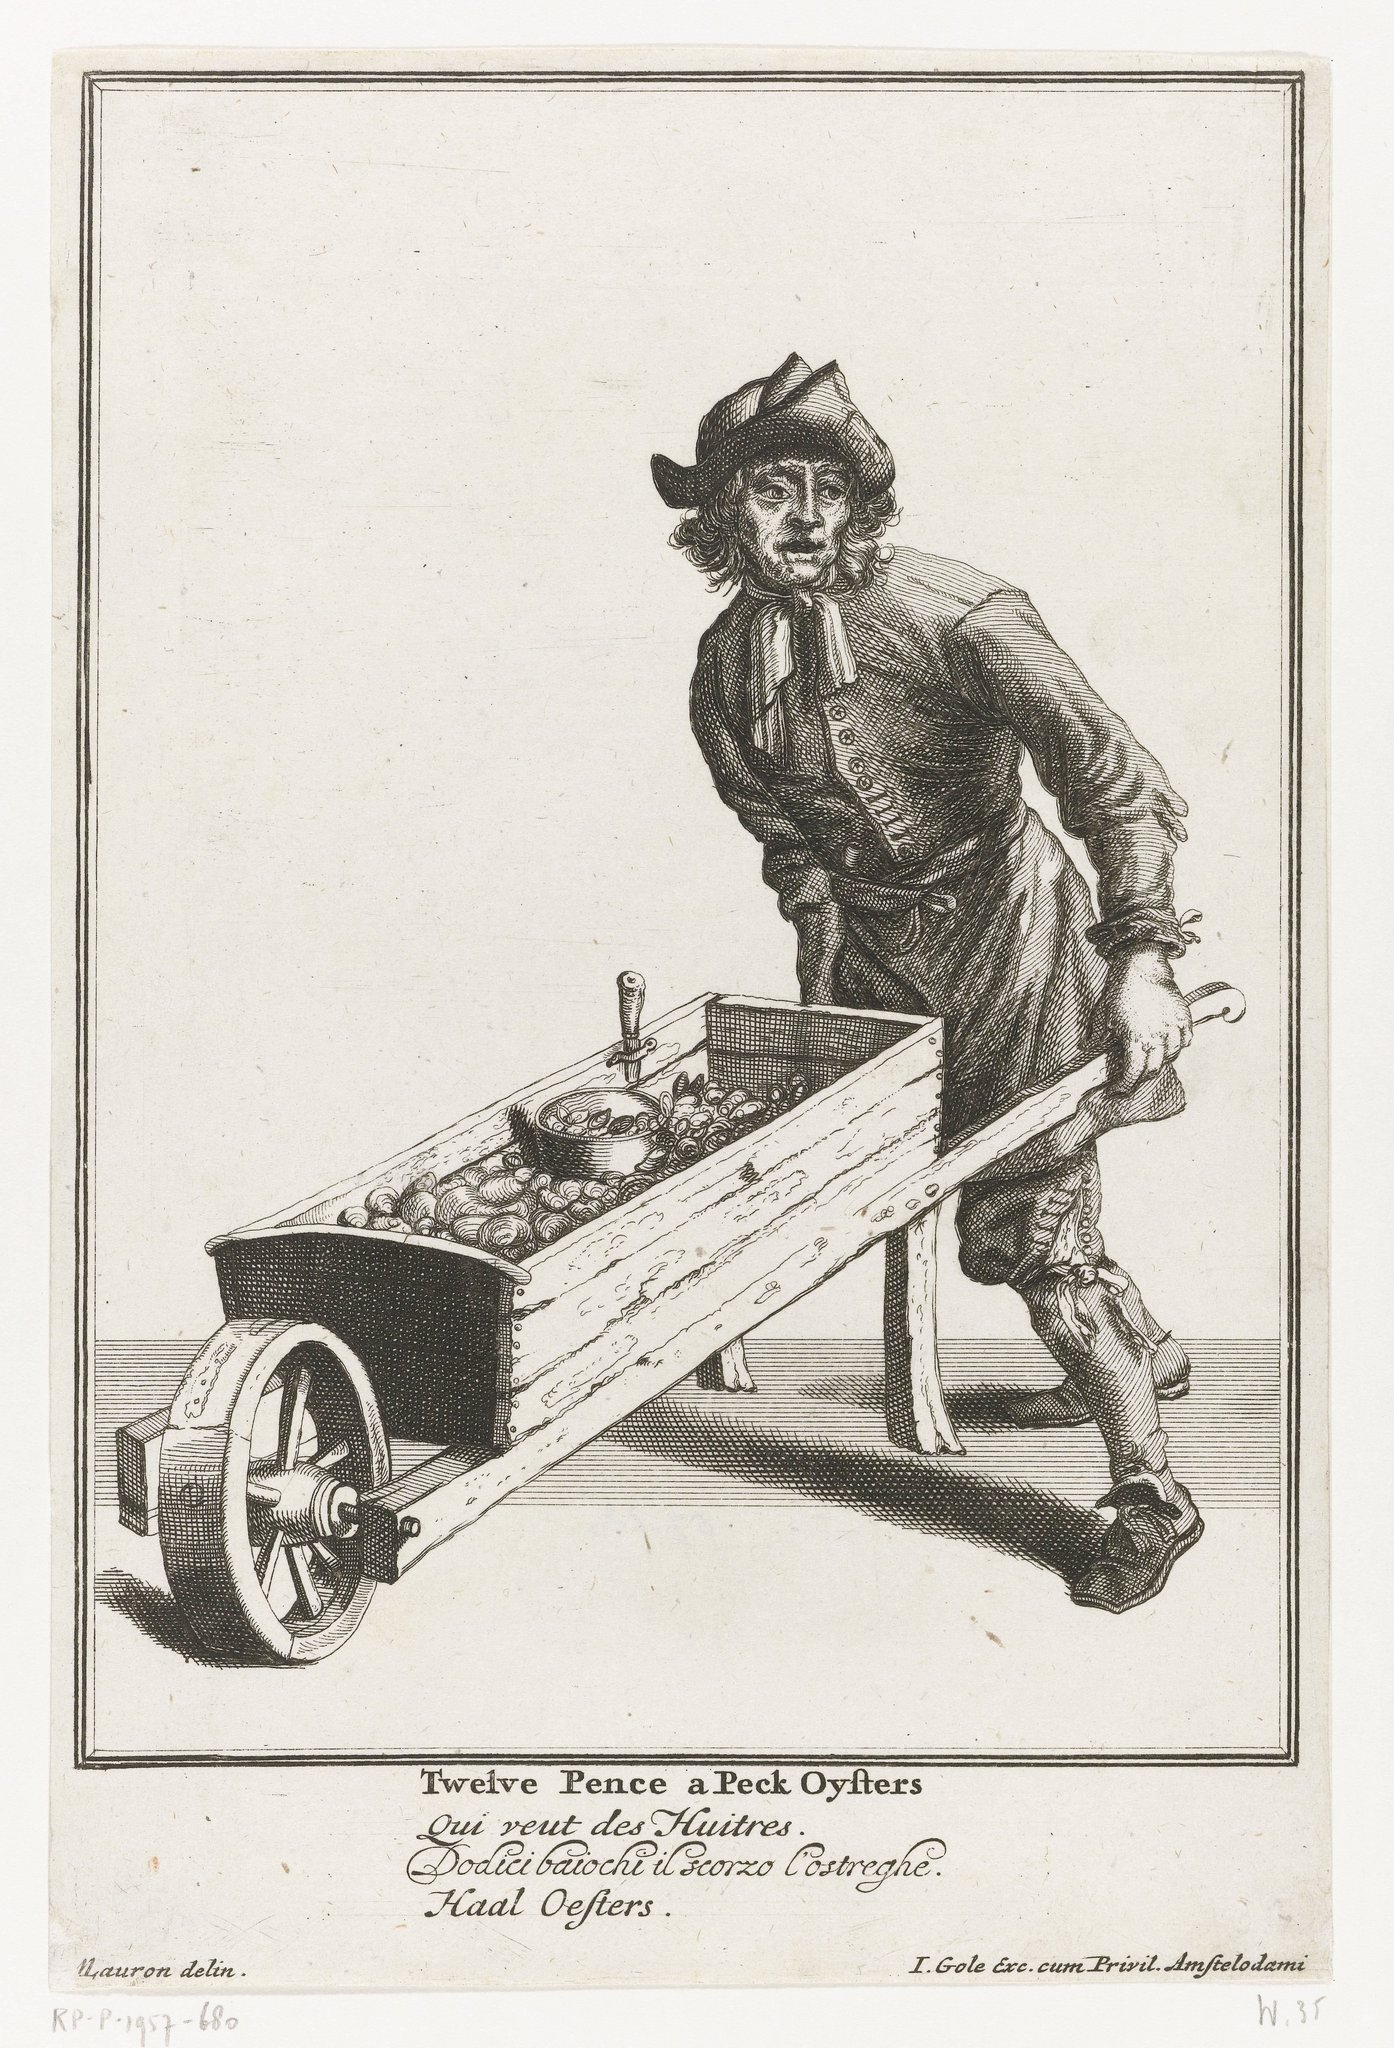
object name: print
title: The Cryes of the City of London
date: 1688-1724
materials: paper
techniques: engraving, etching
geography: london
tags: hand-cart, molluscs: oyster, 'cris de paris', cries of london, etc., oyster and mussel culture (+ trade ~ crafts, industries, agriculture)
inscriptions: collector's mark: Lugt 2228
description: Straatventer, lopend achter een kruiwagen met oesters. De prent heeft een Engels, Frans, Italiaans en Nederlands onderschrift en maakt deel uit van een serie over de straatventers in Londen.